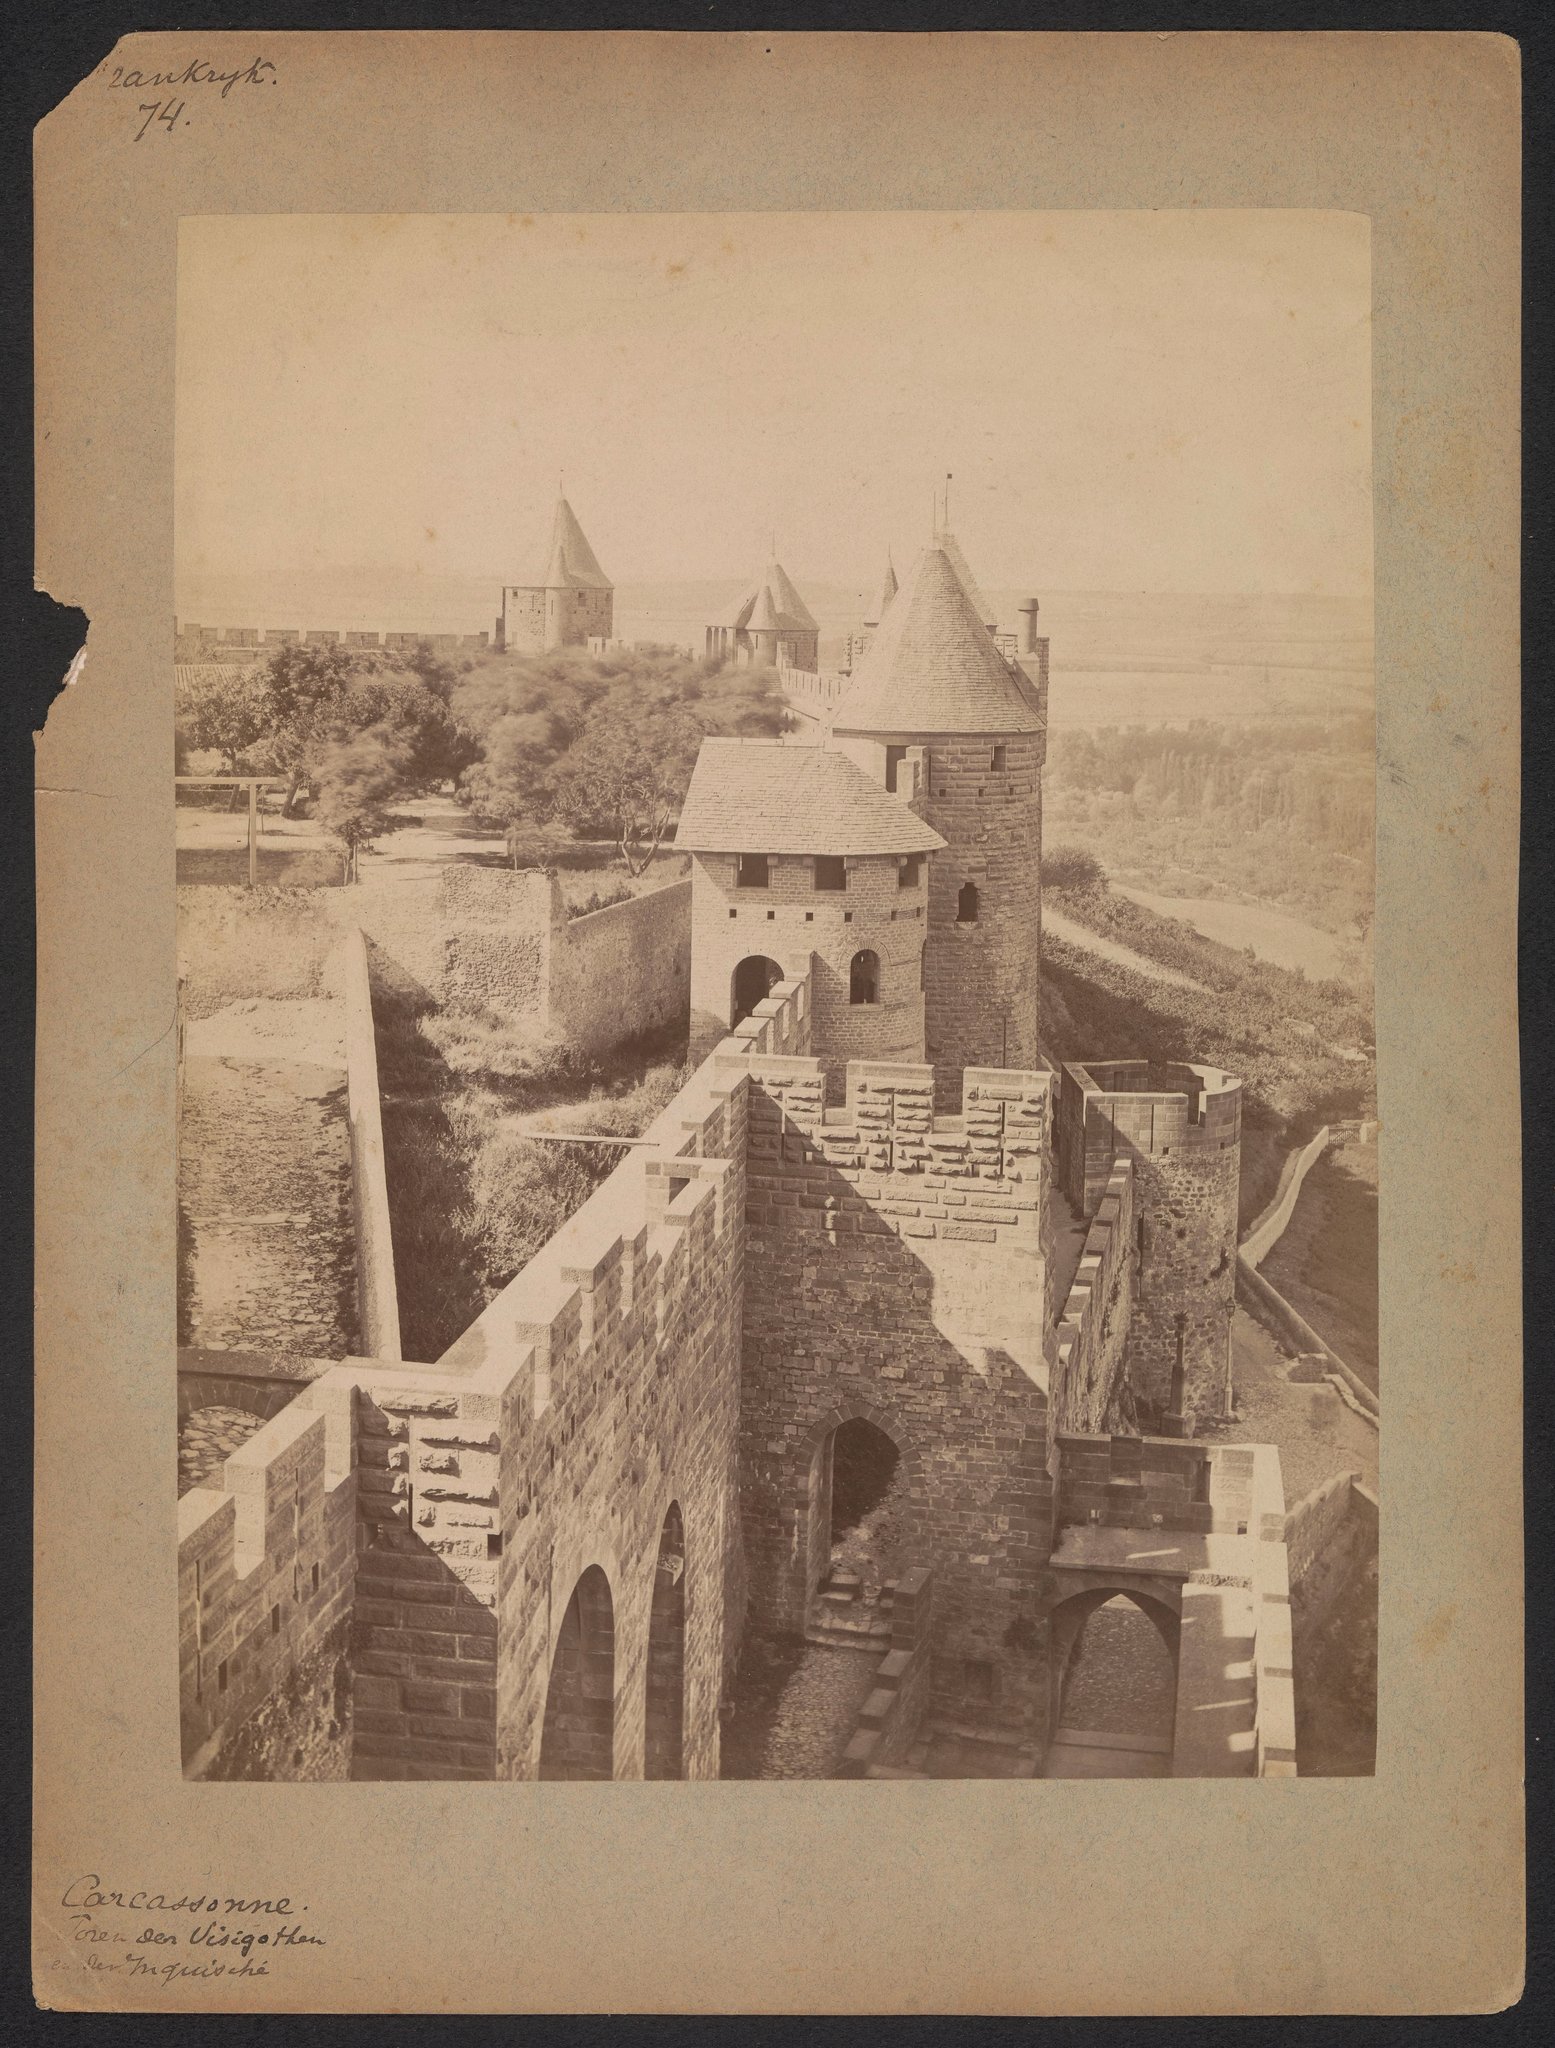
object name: photograph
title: Gezicht op de vesting van Carcasonne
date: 1850-1900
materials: cardboard, photographic support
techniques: albumen print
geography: paris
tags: fortress, city-view, and landscape with man-made constructions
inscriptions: collector's mark: ‘RIJKS-NORMAALSCHOOL voor TEEKENONDERWIJZERS. AMSTERDAM’, annotation: ‘Carcassonne./ Toren den Visigotten/ en der [...]uisché’, check stamp: ‘A. Giraudon/ Éditeur/ 15, R. Bonaparte. Paris’, annotation: ‘Frankrijk./ 74.’